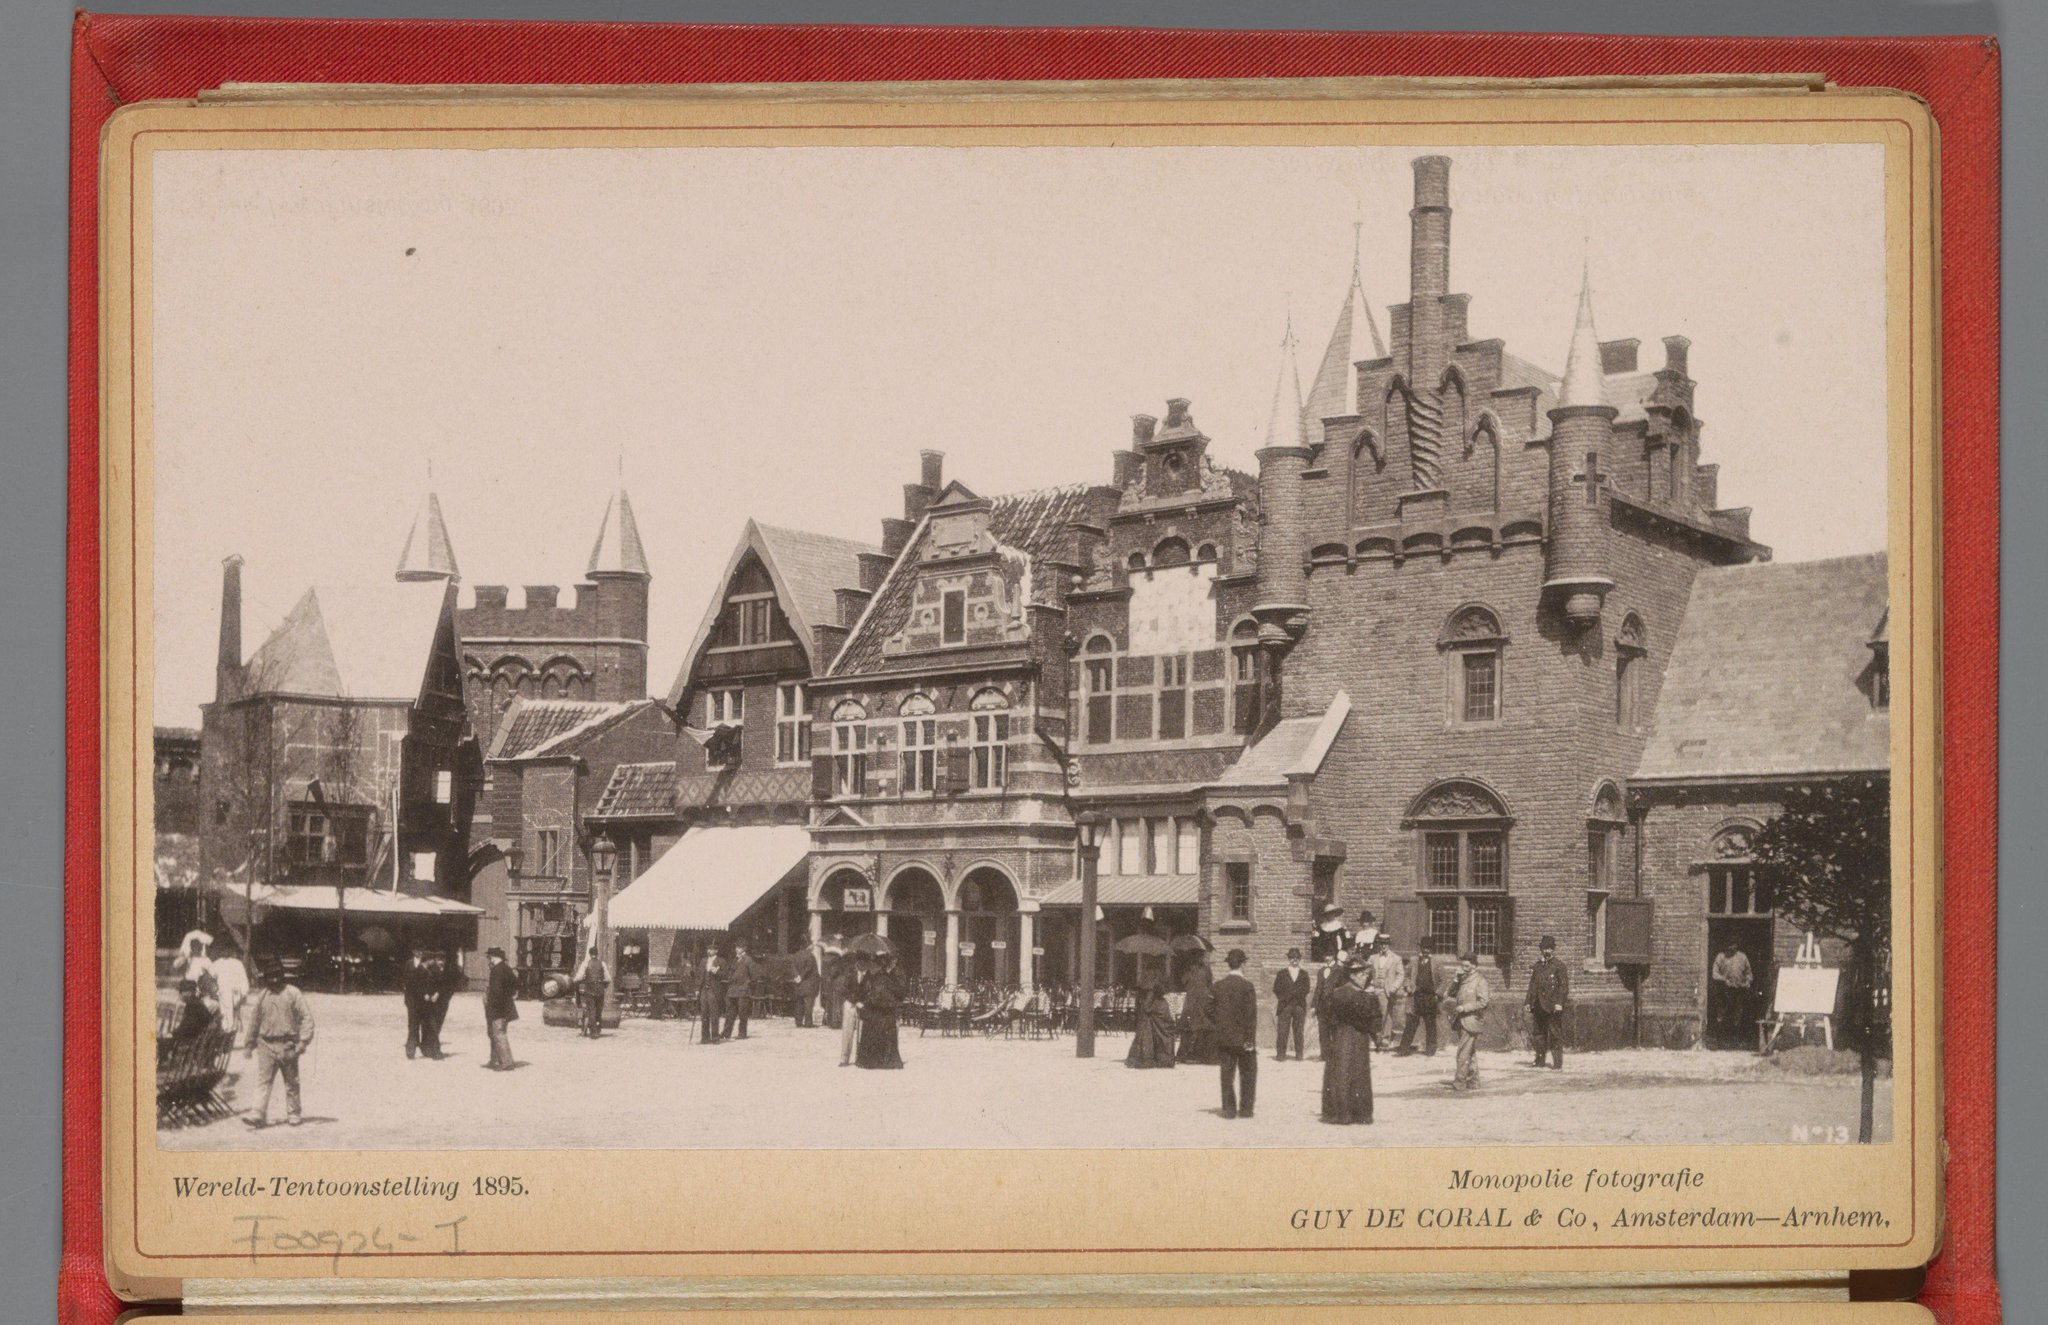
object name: photograph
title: Replica's van oud-Hollandse gevels tijdens de Wereldtentoonstelling voor het Hotel- en Reiswezen op het Museumplein in 1895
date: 1895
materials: cardboard, paper, ink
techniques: photograph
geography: amsterdam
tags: prospect of city, town panorama, silhouette of city, temporary exhibition, 'salon', amsterdam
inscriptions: number: ‘no. 13’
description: Onderdeel van Fotoalbum met opnames van de Wereldtentoonstelling voor het Hotel- en Reiswezen op het Museumplein in 1895.